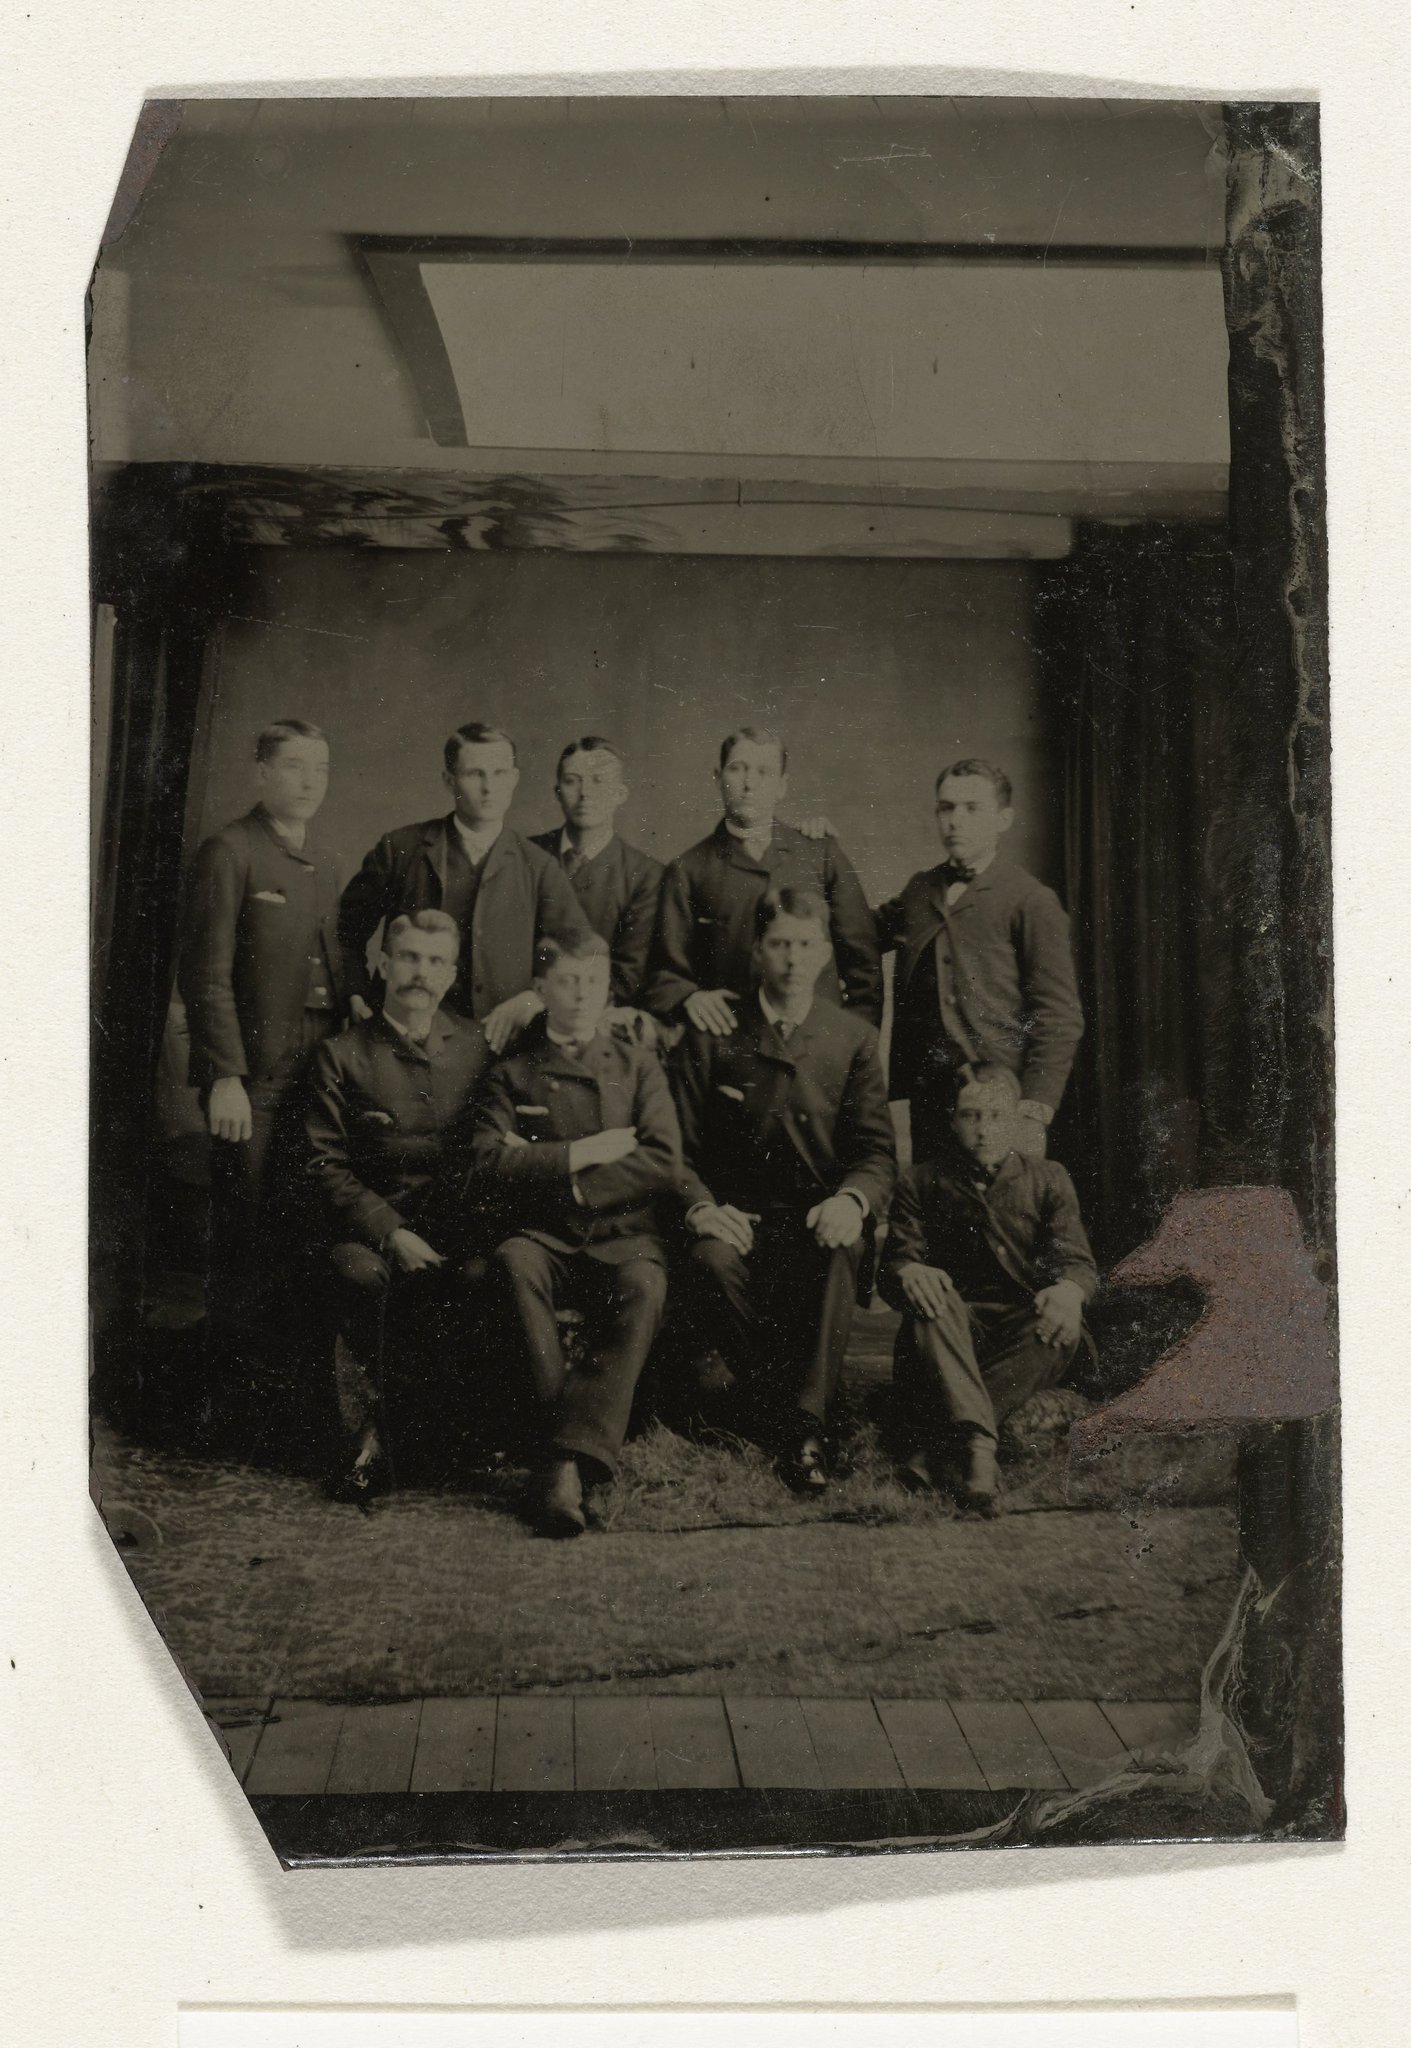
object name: photograph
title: Groepsportret van negen mannen in een atelier, met in het plafond een wit reflectiescherm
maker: Anonymous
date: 1880-1910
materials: metal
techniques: ferrotyping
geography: united states